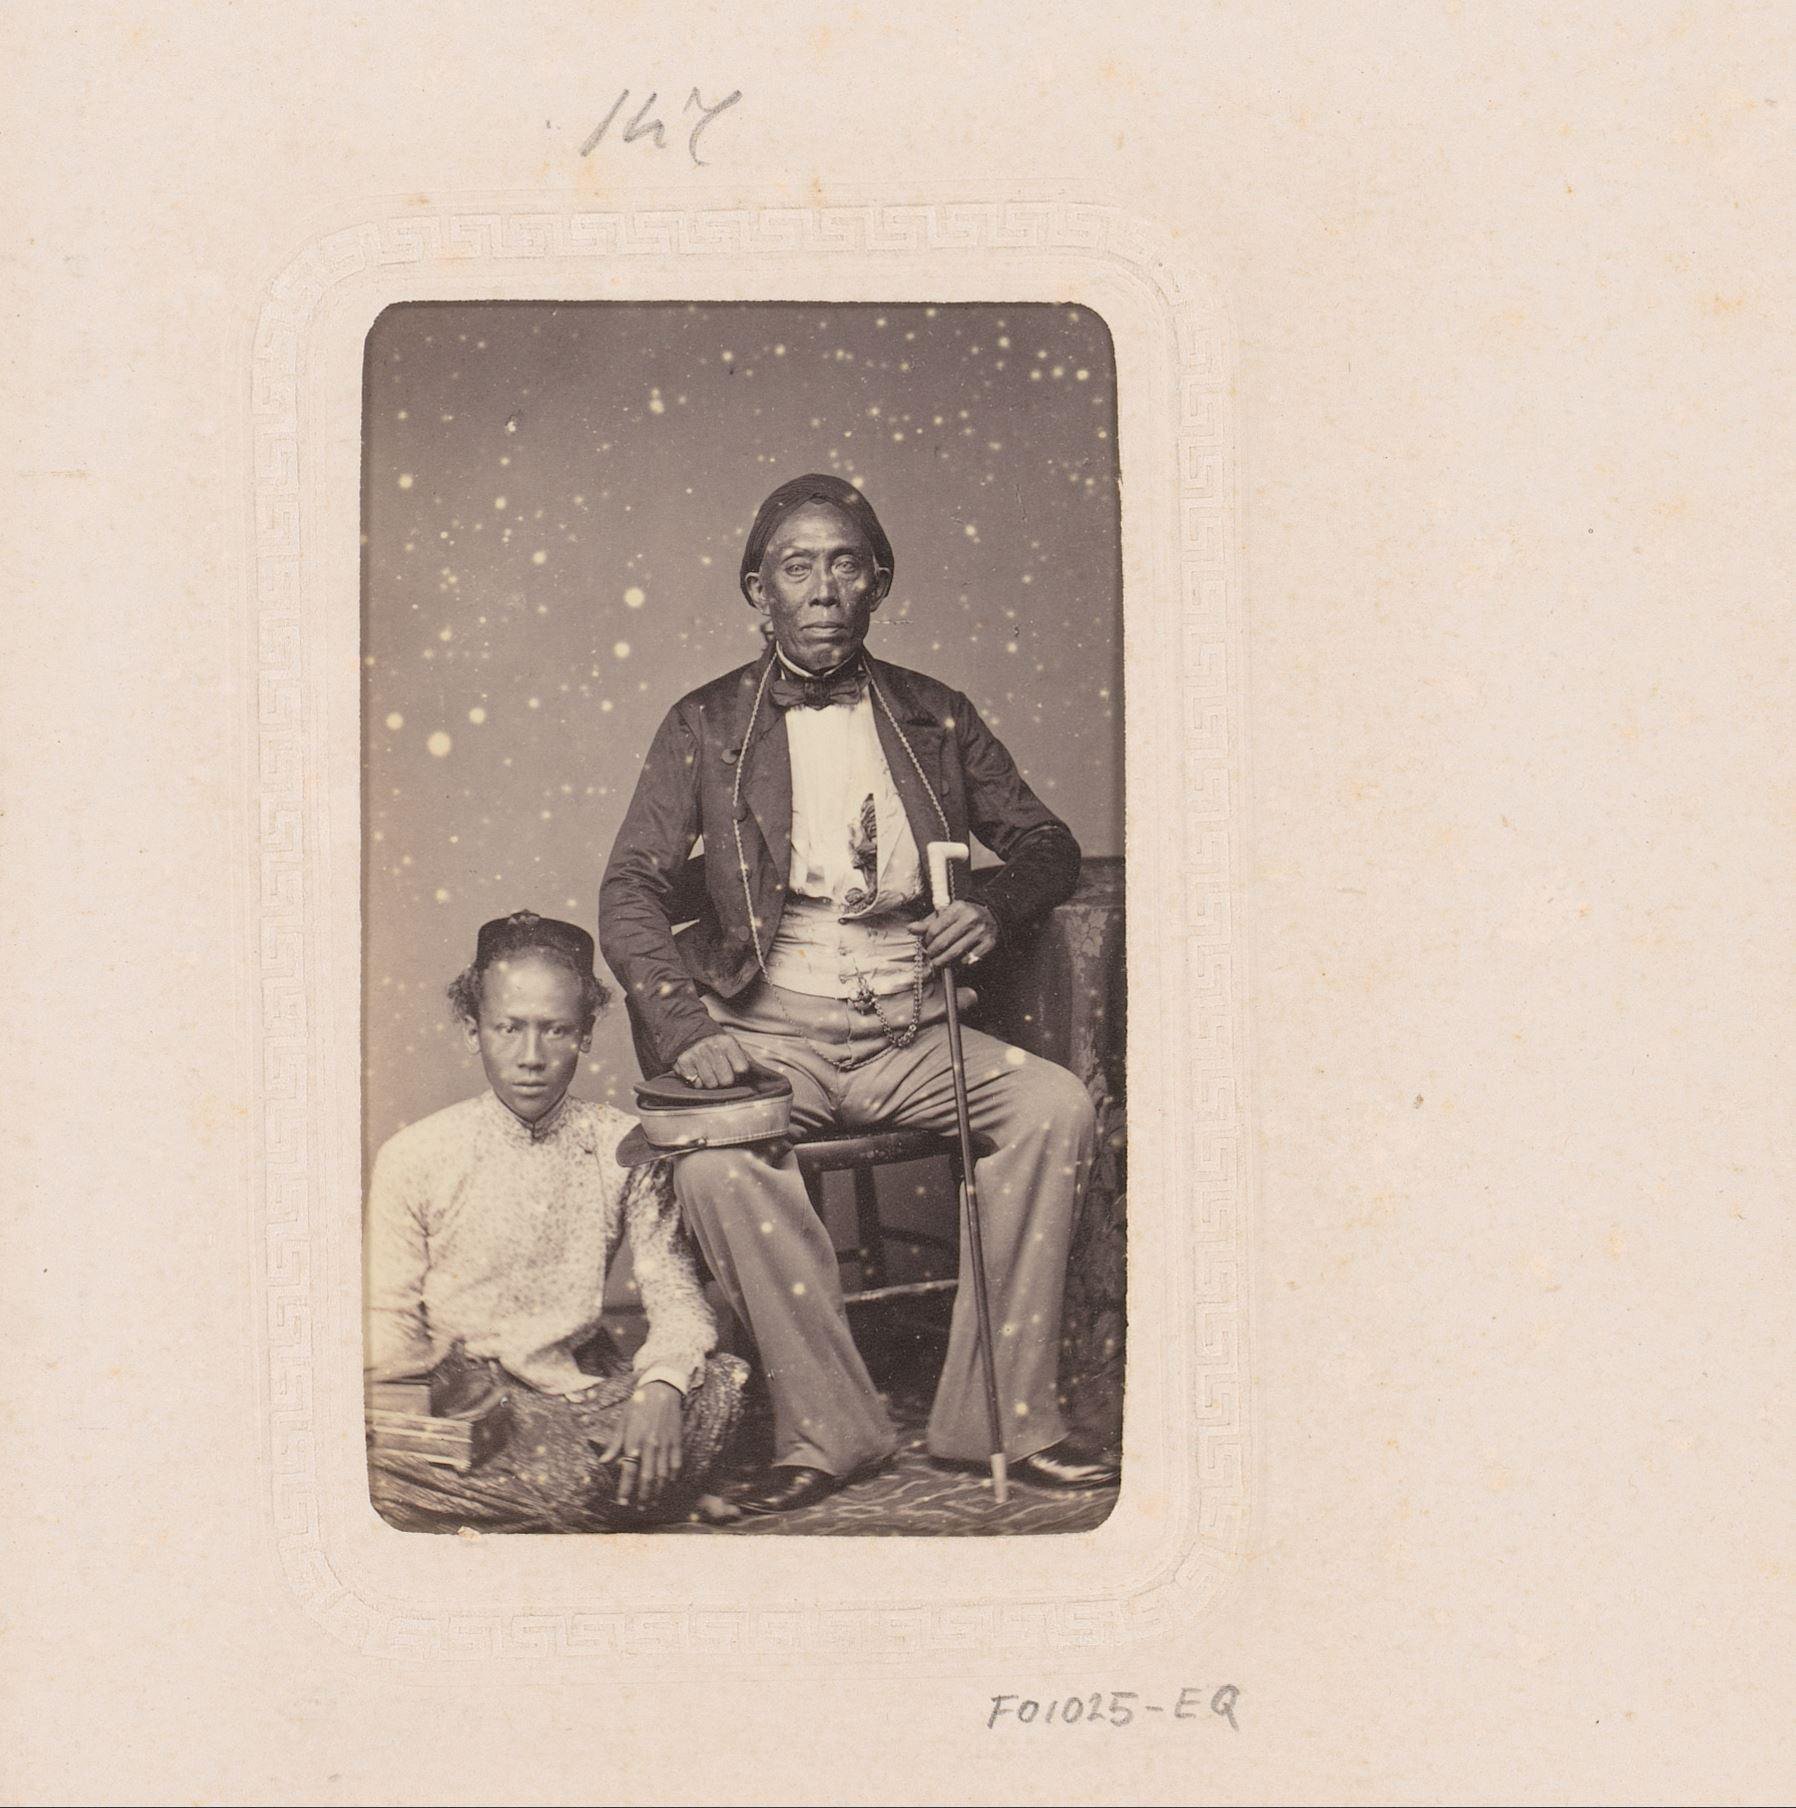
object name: photograph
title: Portret van een oude Indonesische man en een jongen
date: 1857-1880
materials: cardboard, photographic support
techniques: albumen print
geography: java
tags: boy (child between toddler and youth), historical persons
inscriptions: inscription: ‘Woodbury & Page/ Photographers/ Java’, number: ‘147’